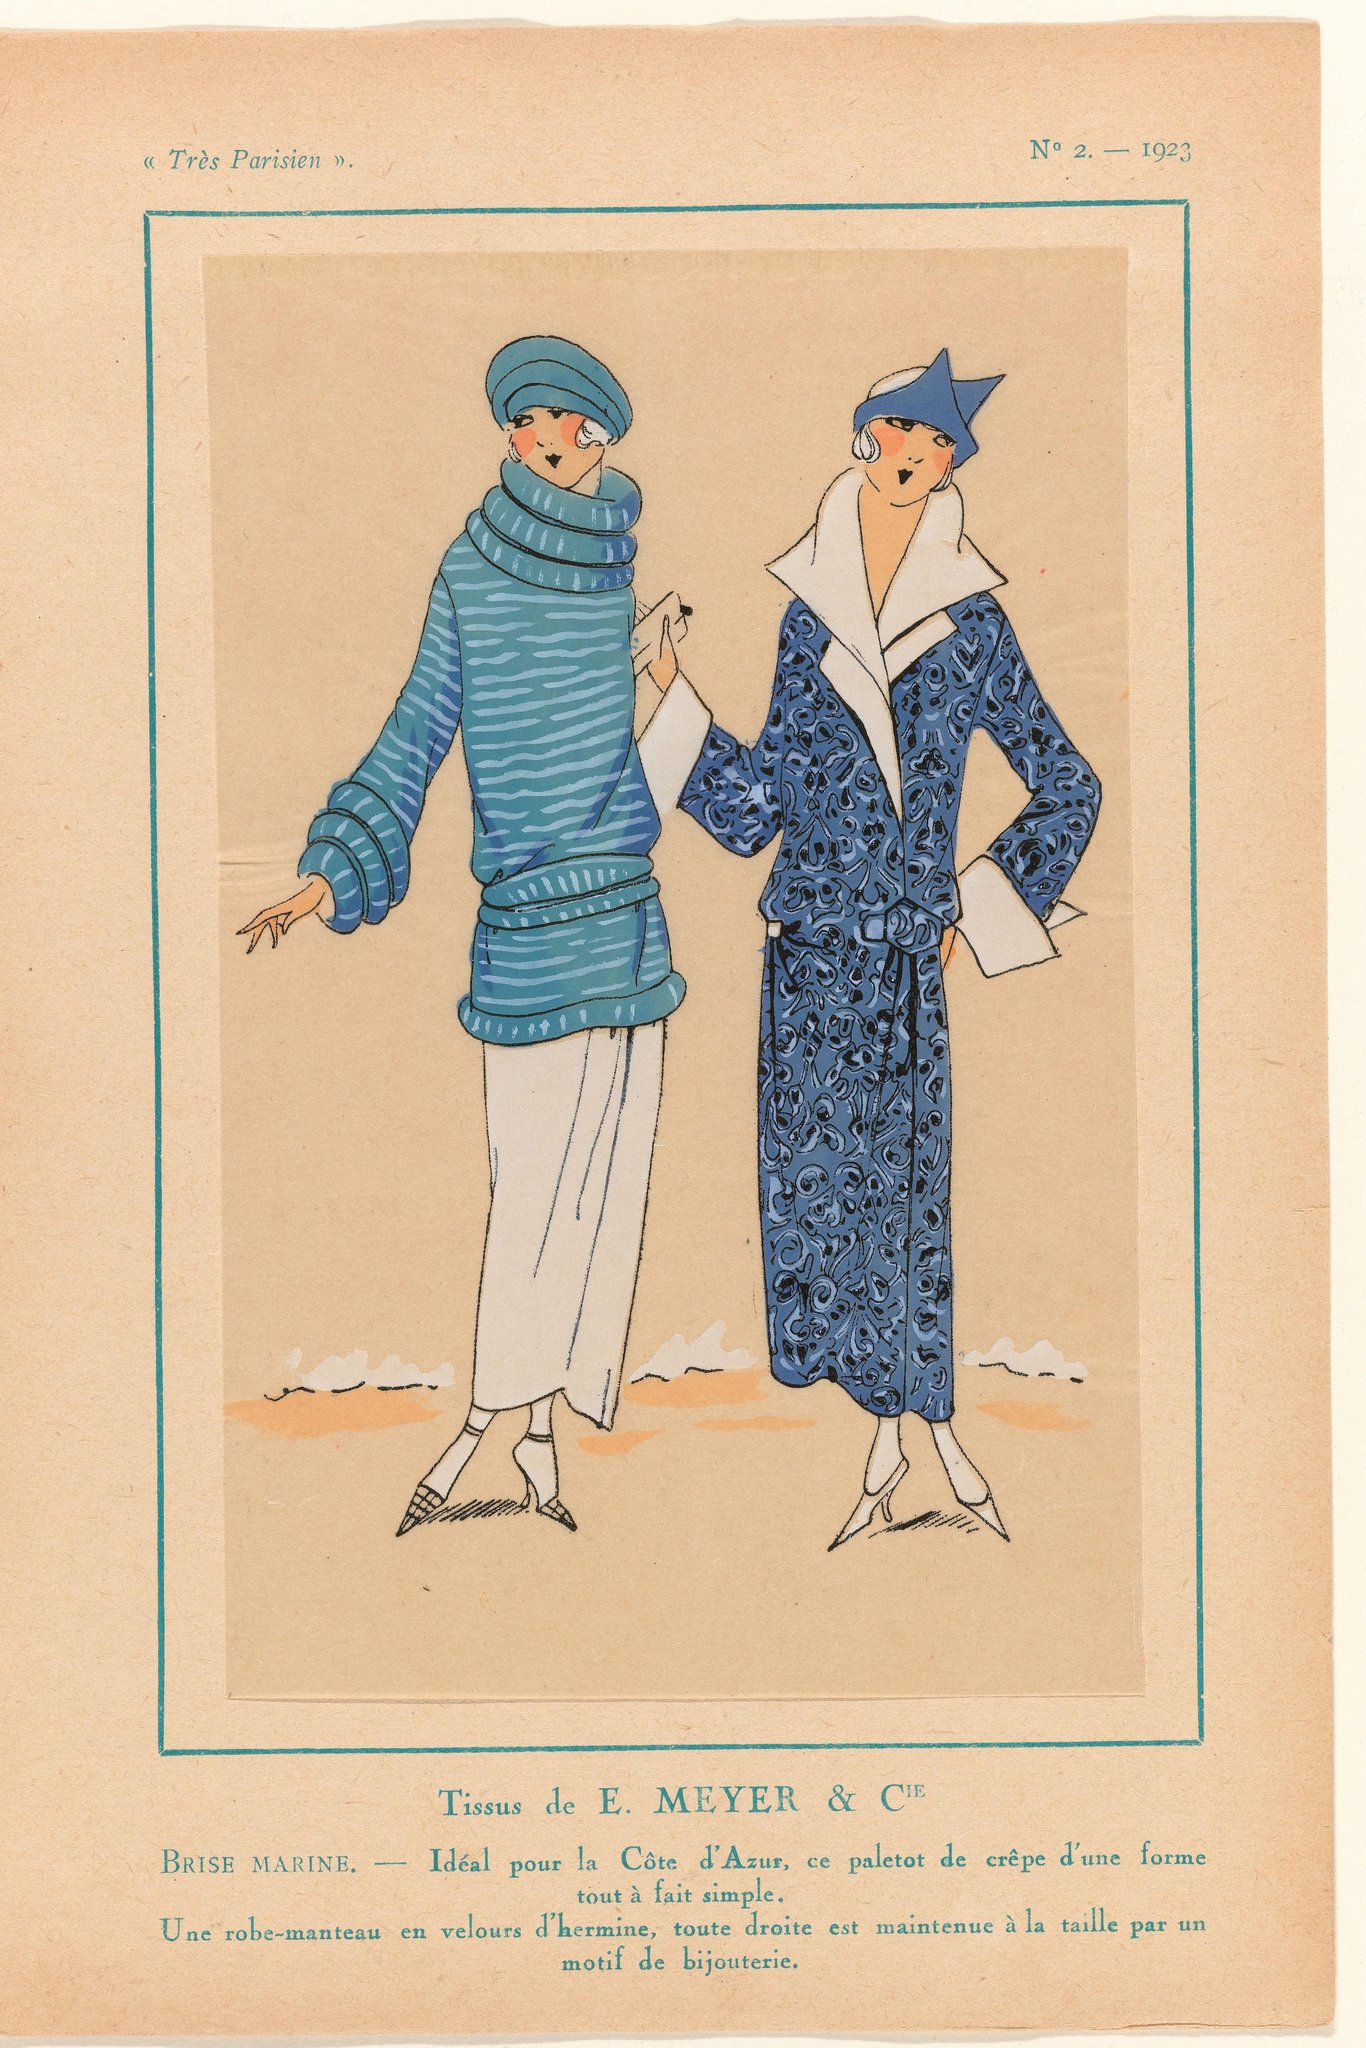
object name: fashion print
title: Très Parisien, 1923, No. 2: Tissus de E. MEYER & CIE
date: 1923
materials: paper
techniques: hand coloring, letterpress printing, lithography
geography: paris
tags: clothing for the upper part of the body (+ women's clothes), dress, gown (robe manteau) (+ women's clothes), fashion plates, head-gear: hat (+ women's clothes), skirt (+ women's clothes)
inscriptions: title: ‘Très Parisien / No 2. - 1923’, caption: ‘Tissus de E. MEYER & CIE / BRISE MARINE. - Idéal pour la Côte d'Azur, ce paletot de crêpe d'une forme tout à fait simple. Une robe-manteau en velours d'hermine, toute droite est maintenue à la taille par un motif de bijouterie.’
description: Stoffen van E. Meyer & Cie. Ideaal voor aan de Côte d'Azur, deze 'paletot' van crêpe heeft een eenvoudige vorm. Een 'robe-manteau' (jasjurk) van 'velours d'hermine', die geheel rechts in de taille bijeengehouden wordt middels een 'motif de bijouterie'. Prent uit het modetijdschrift Très Parisien (1920-1936).